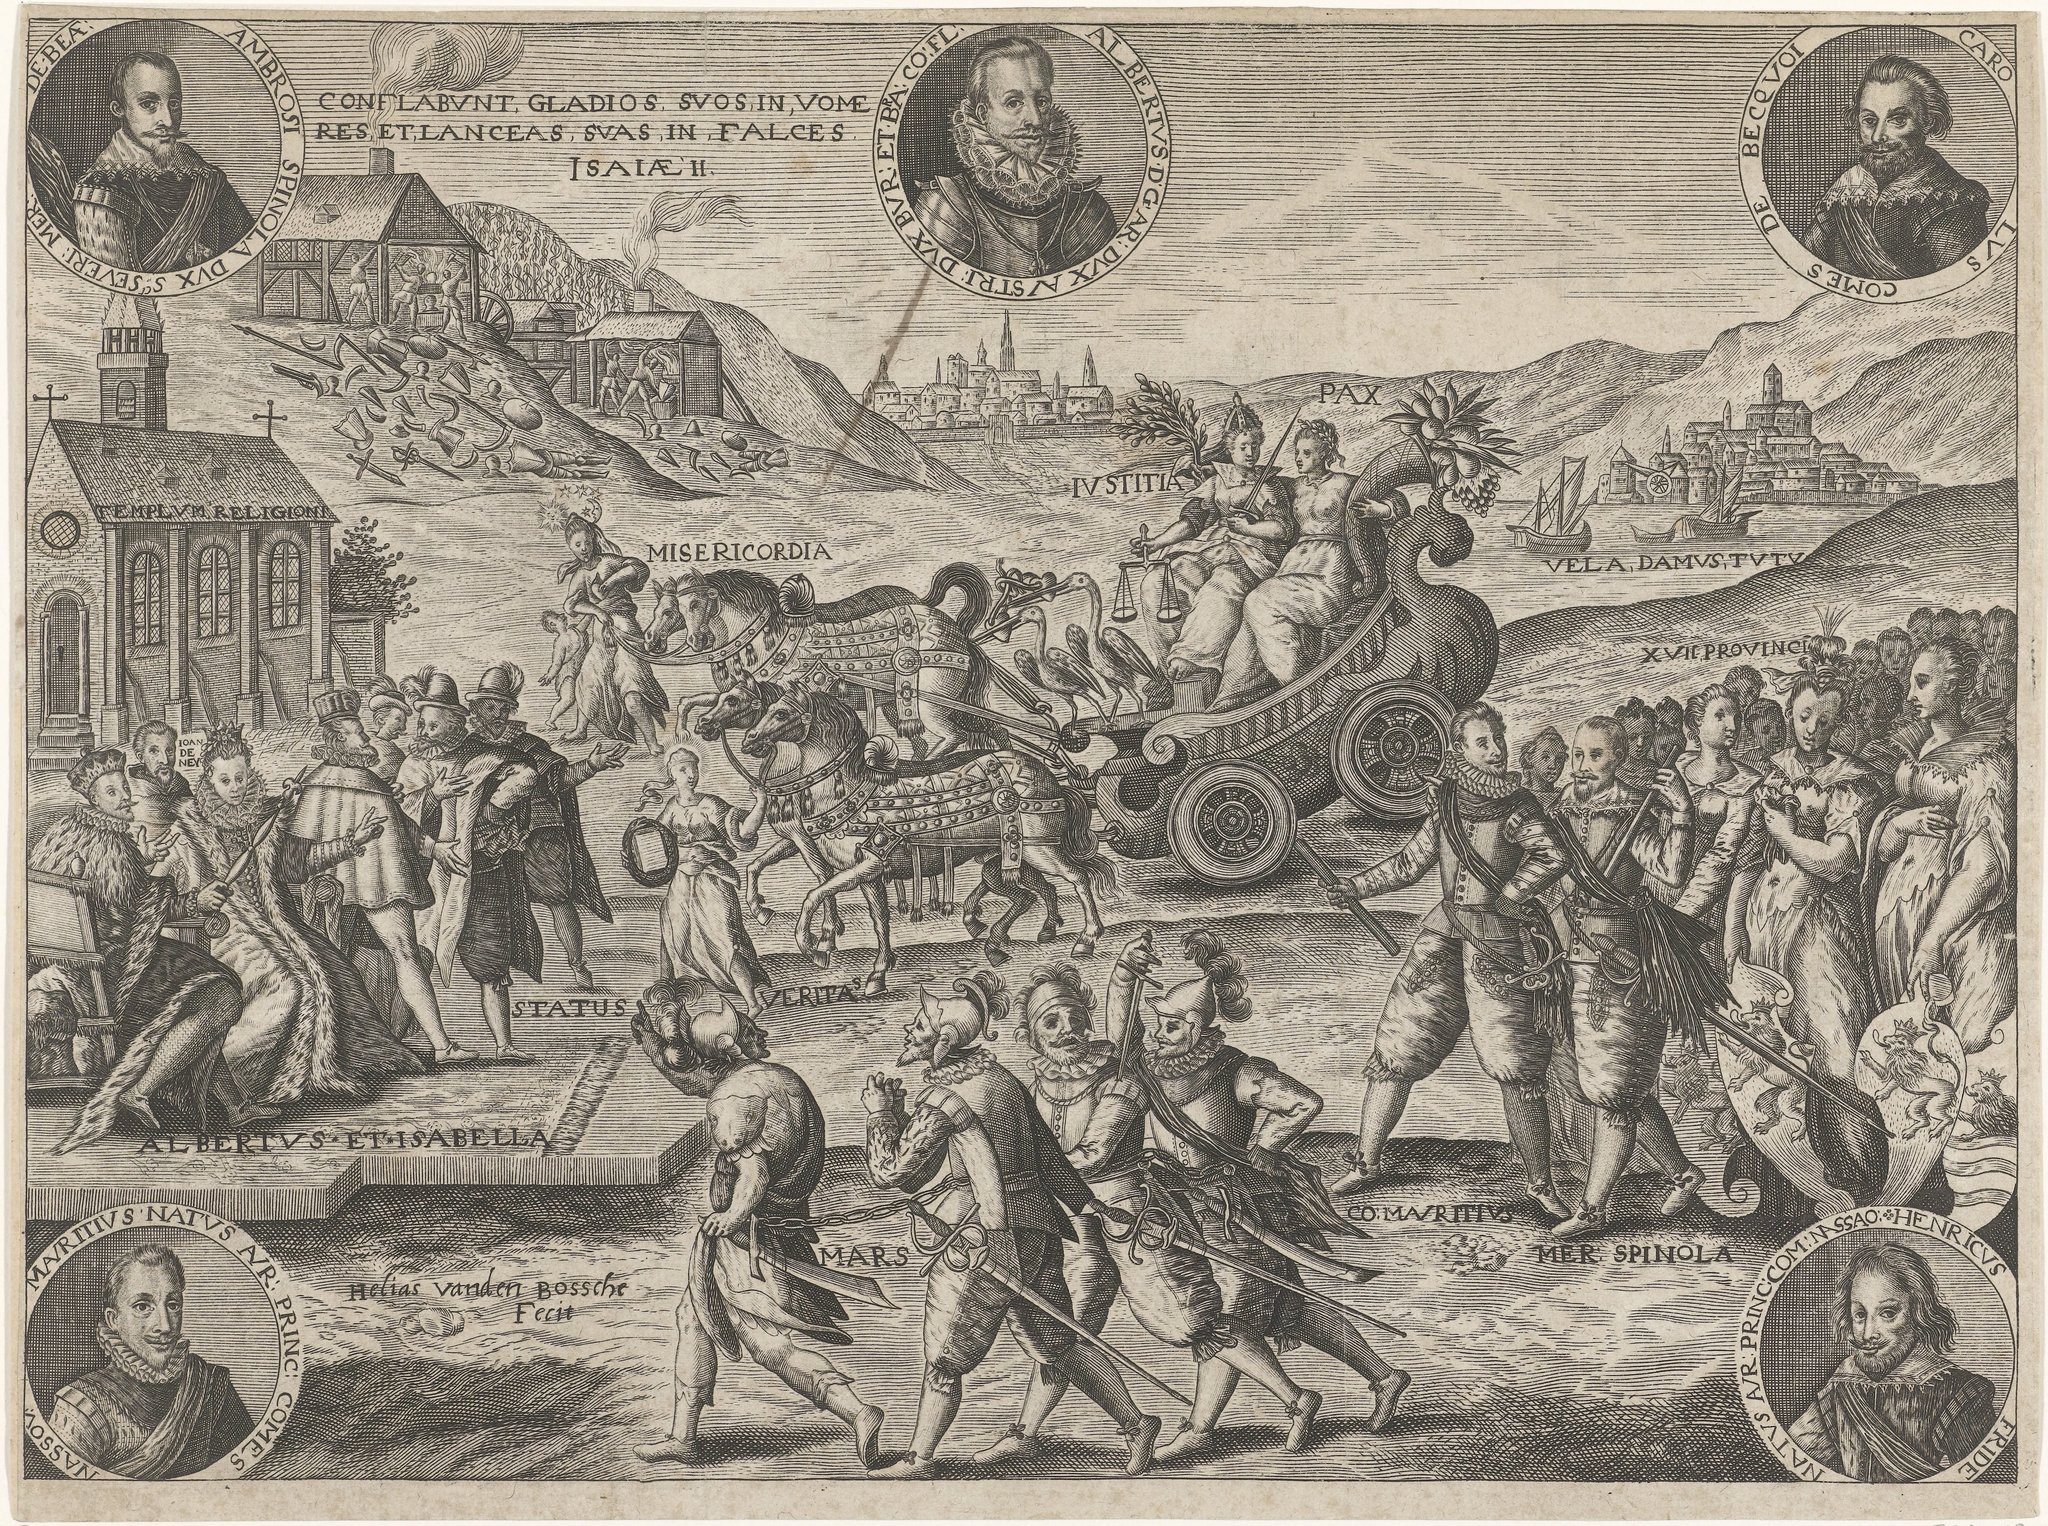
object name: propagandaprent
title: Allegorie op het Bestand en de vereniging der partijen, 1609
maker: elias van den bossche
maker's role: print maker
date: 1609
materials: paper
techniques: engraving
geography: northern netherlands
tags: delft, frederick henry (prince of orange), the hague, maurice (prince of orange), infante van spanje isabella clara eugenia, brussels, albrecht aartshertog van oostenrijk, antwerp, spain, justice, 'justitia'; 'giustitia divina' (ripa) ~ one of the four cardinal virtues, symbols, allegories of peace, 'pax'; 'pace' (ripa), blessings of peace, isaiah's prophecy of the swords beaten into plough-shares, mercy, compassion; 'compassione', 'misericordia' (ripa) (+ abstract concept represented by female figure), truth; 'verità' (ripa) (+ abstract concept represented by female figure), chariot, triumphal car, symbols, allegories of war; 'guerra' (ripa), signing of peace treaty, concluding the peace, specific aspects, allegorical aspects of mars; mars as patron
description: Allegorie op de met het Bestand bereikte vrede, 1609. Links aartshertog Albrecht en Isabella, Jan Neyen en vertegenwoordigers van de Staten-Generaal. Rechts leiden Maurits en Spinola gezamenlijk de stoet van alle 17 provinciemaagden. In het midden de triomfwagen van de Vrede (Pax) begeleid door Rechtvaardigheid (Justitia), Barmhartigheid (Misericordia) en Waarheid (Veritas), op de voorgrond wordt de oorlogsgod Mars geboeid afgevoerd. Op de achtergrond het omsmeden van zwaarden tot ploegscharen. Boven drie medaillons met portretten van Spinola, Albrecht en de graaf van Bucquoy. Onderaan twee medaillons met portretten van Maurits en Frederik Hendrik.